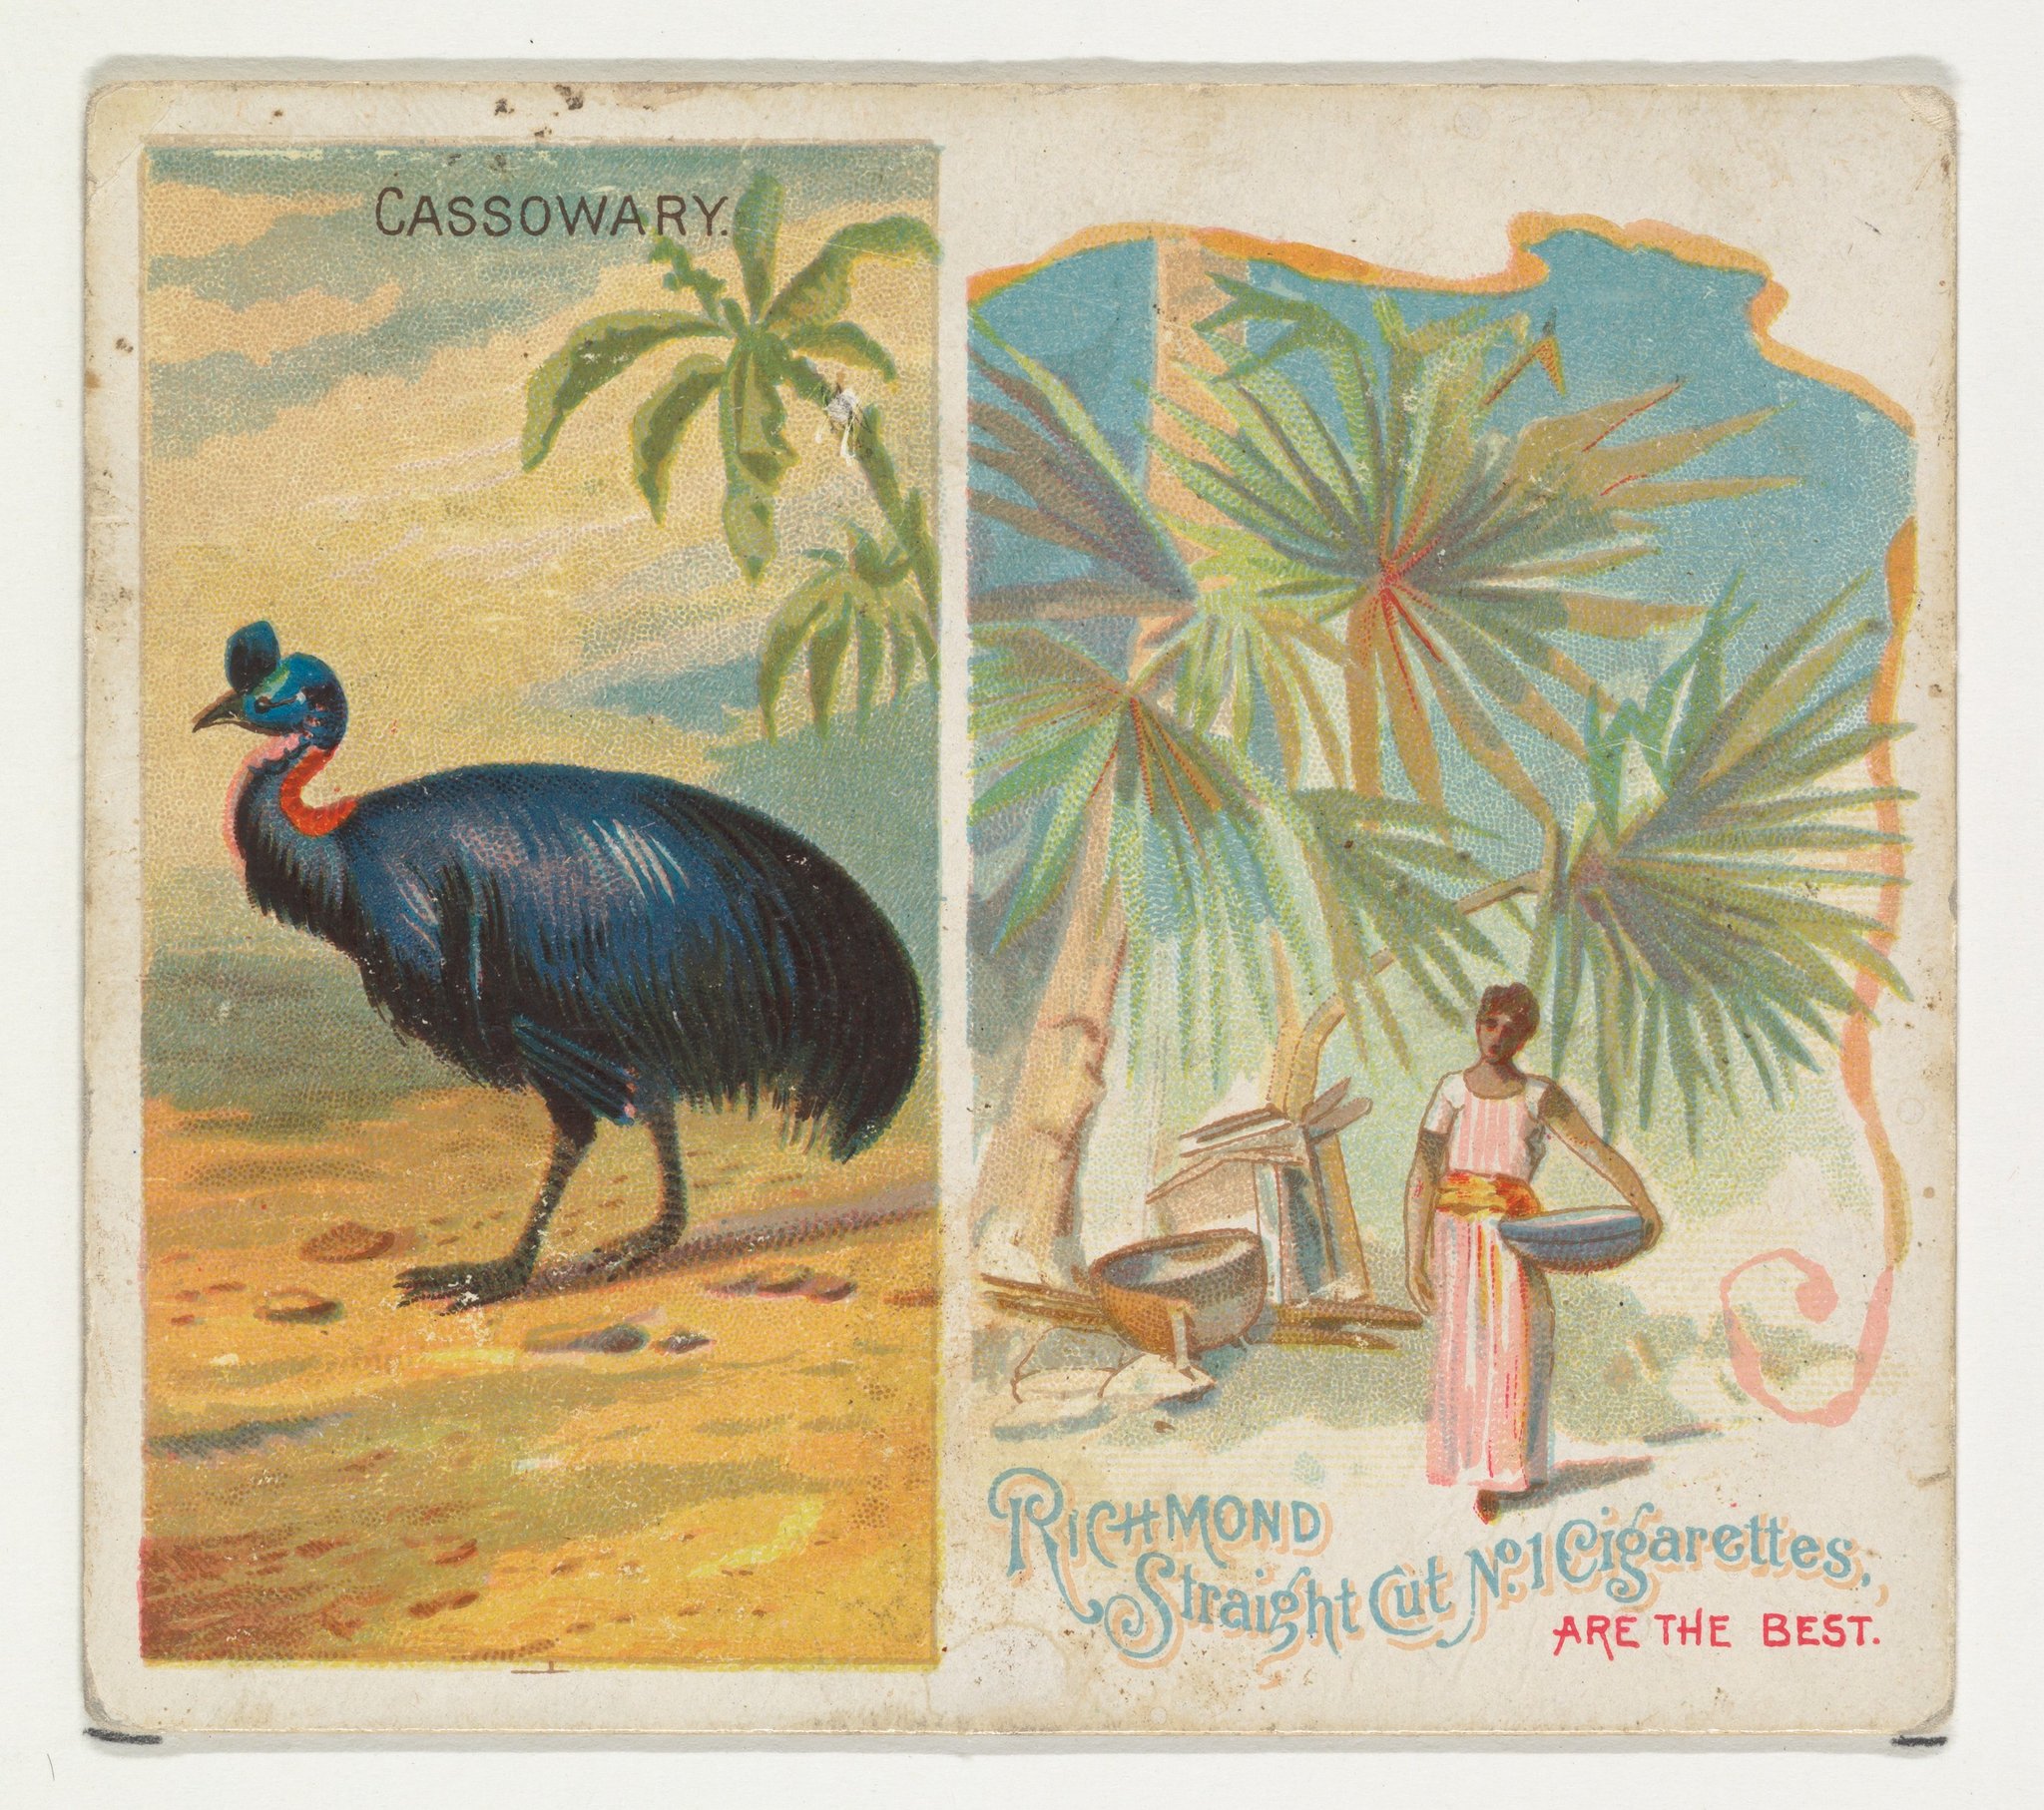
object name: print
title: Cassowary, from Birds of the Tropics series (N38) for Allen & Ginter Cigarettes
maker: allen & ginter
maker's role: publisher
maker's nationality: american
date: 1889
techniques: color lithograph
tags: birds